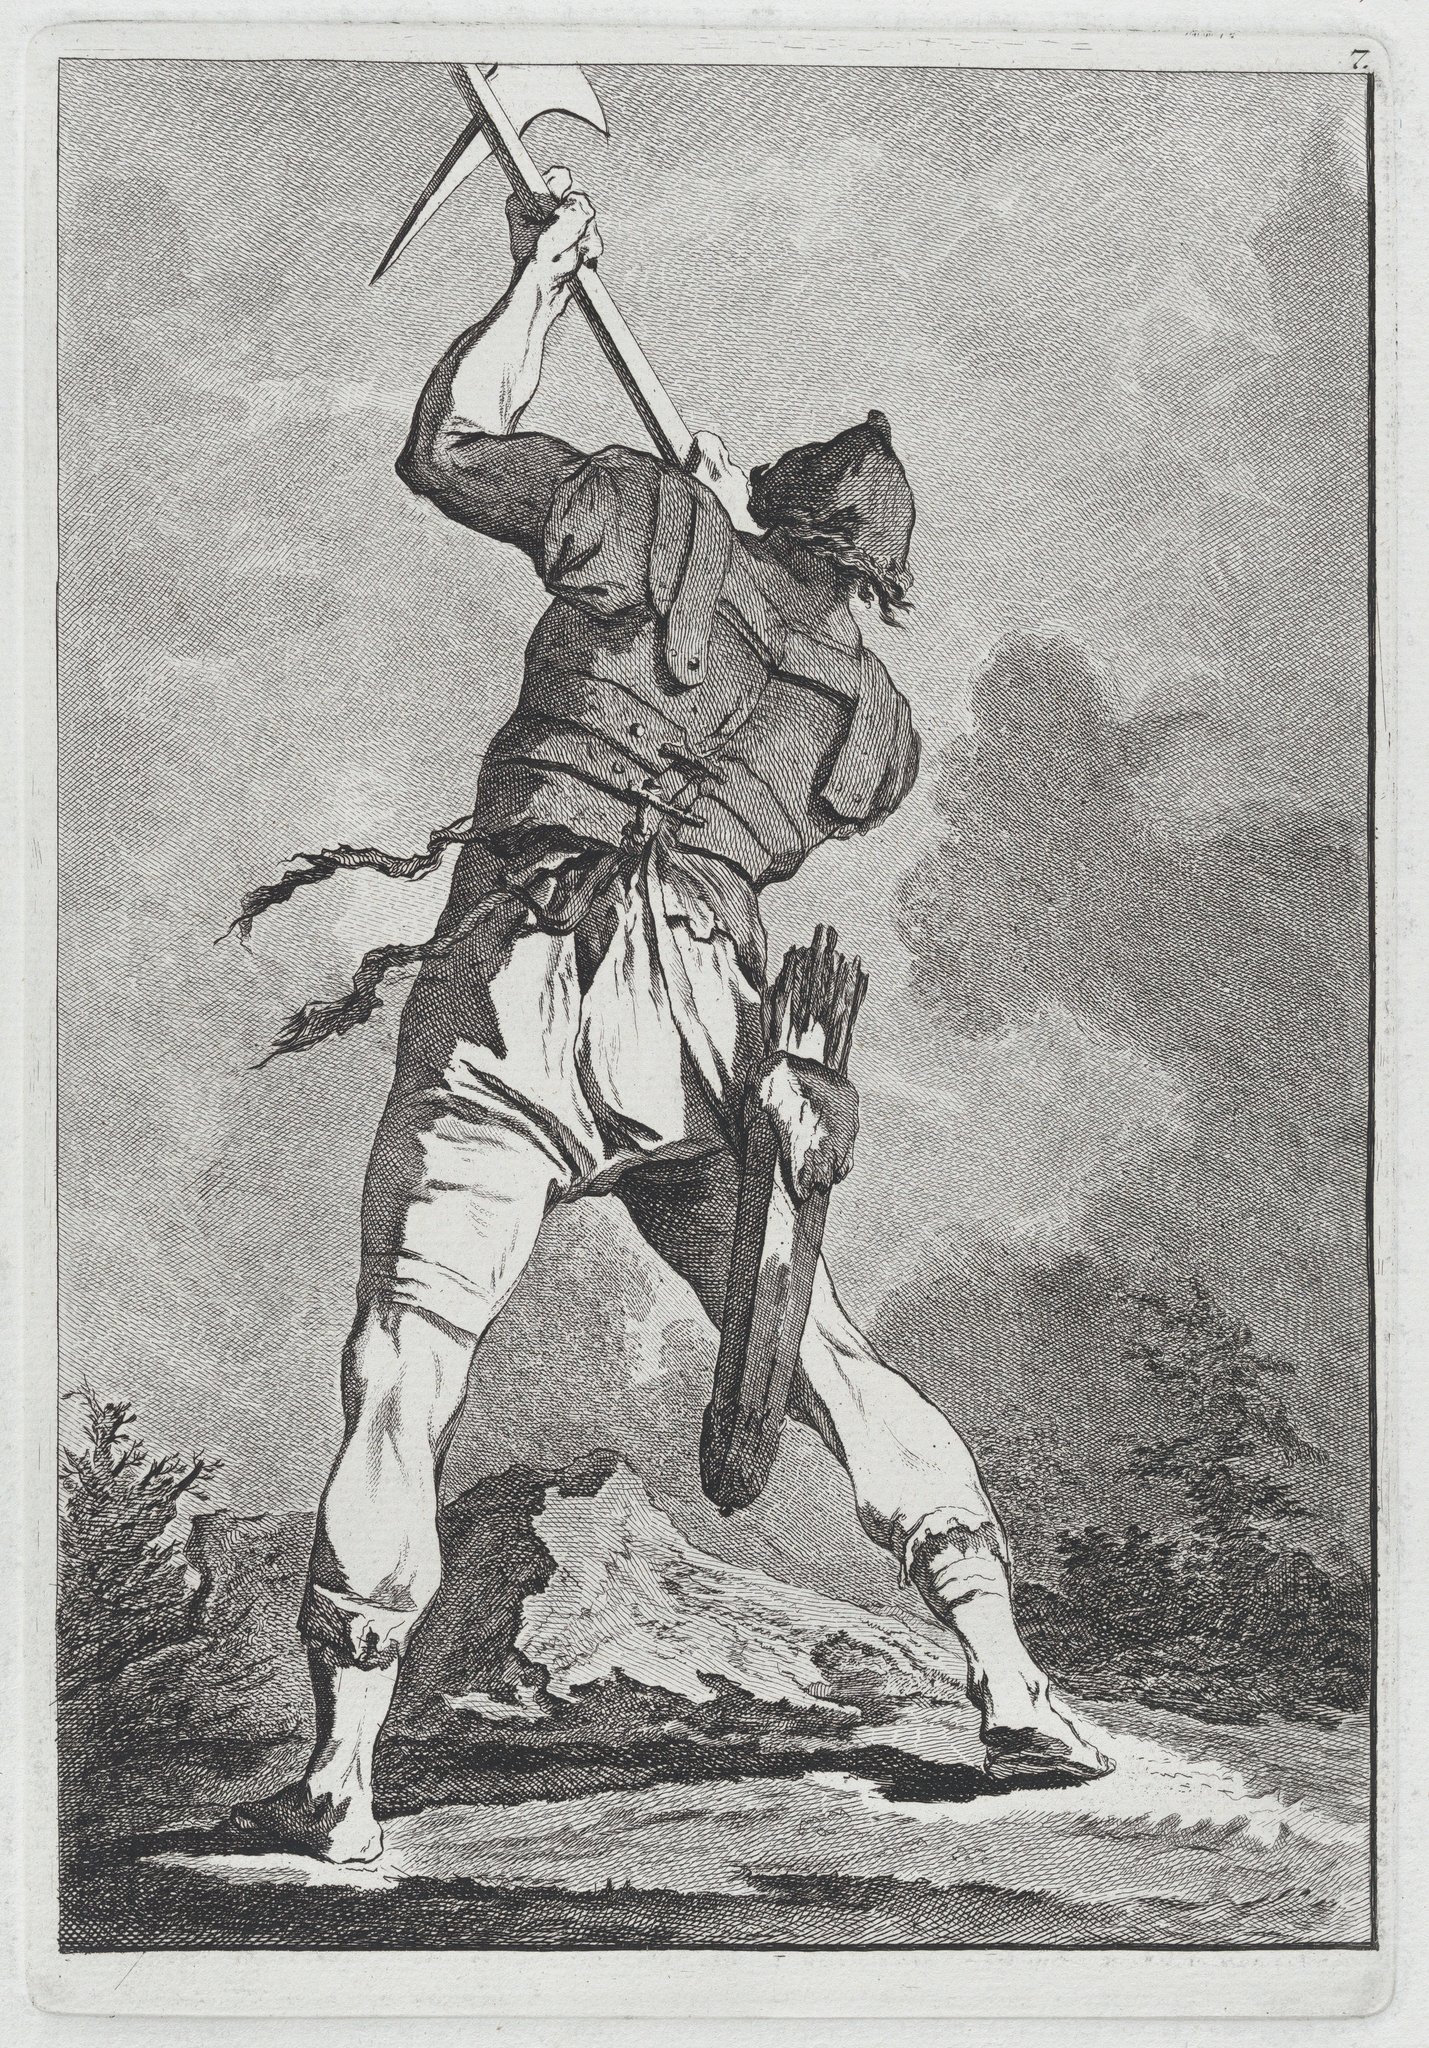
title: Soldier Wielding a Weapon, Seen from Behind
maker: matthias pfenninger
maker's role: etcher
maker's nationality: swiss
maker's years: 1739-1813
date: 1764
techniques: etching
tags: soldiers,weapons,men